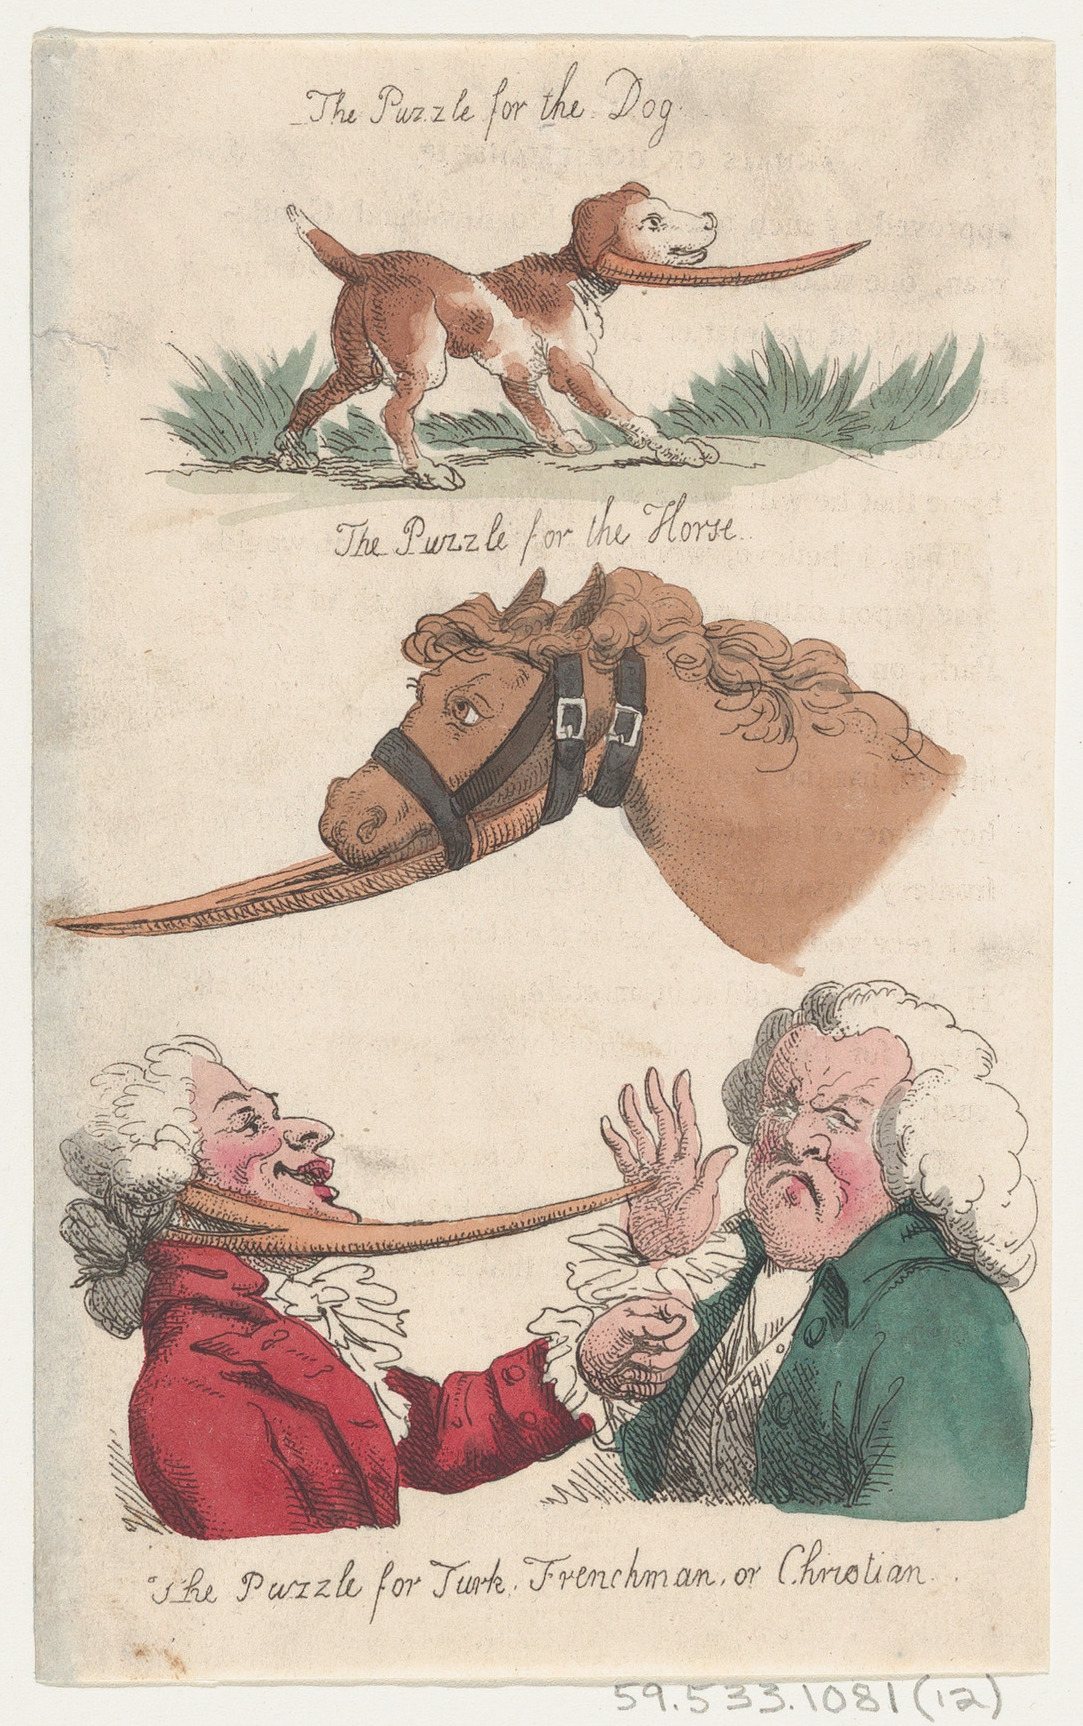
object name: print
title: The Puzzle for the Dog; The Puzzle for the Horse; The Puzzle for Turk, Frenchman, or Christian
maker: thomas rowlandson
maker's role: artist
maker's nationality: british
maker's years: 1757-1827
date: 1808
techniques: etching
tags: satire,men,dogs,horses